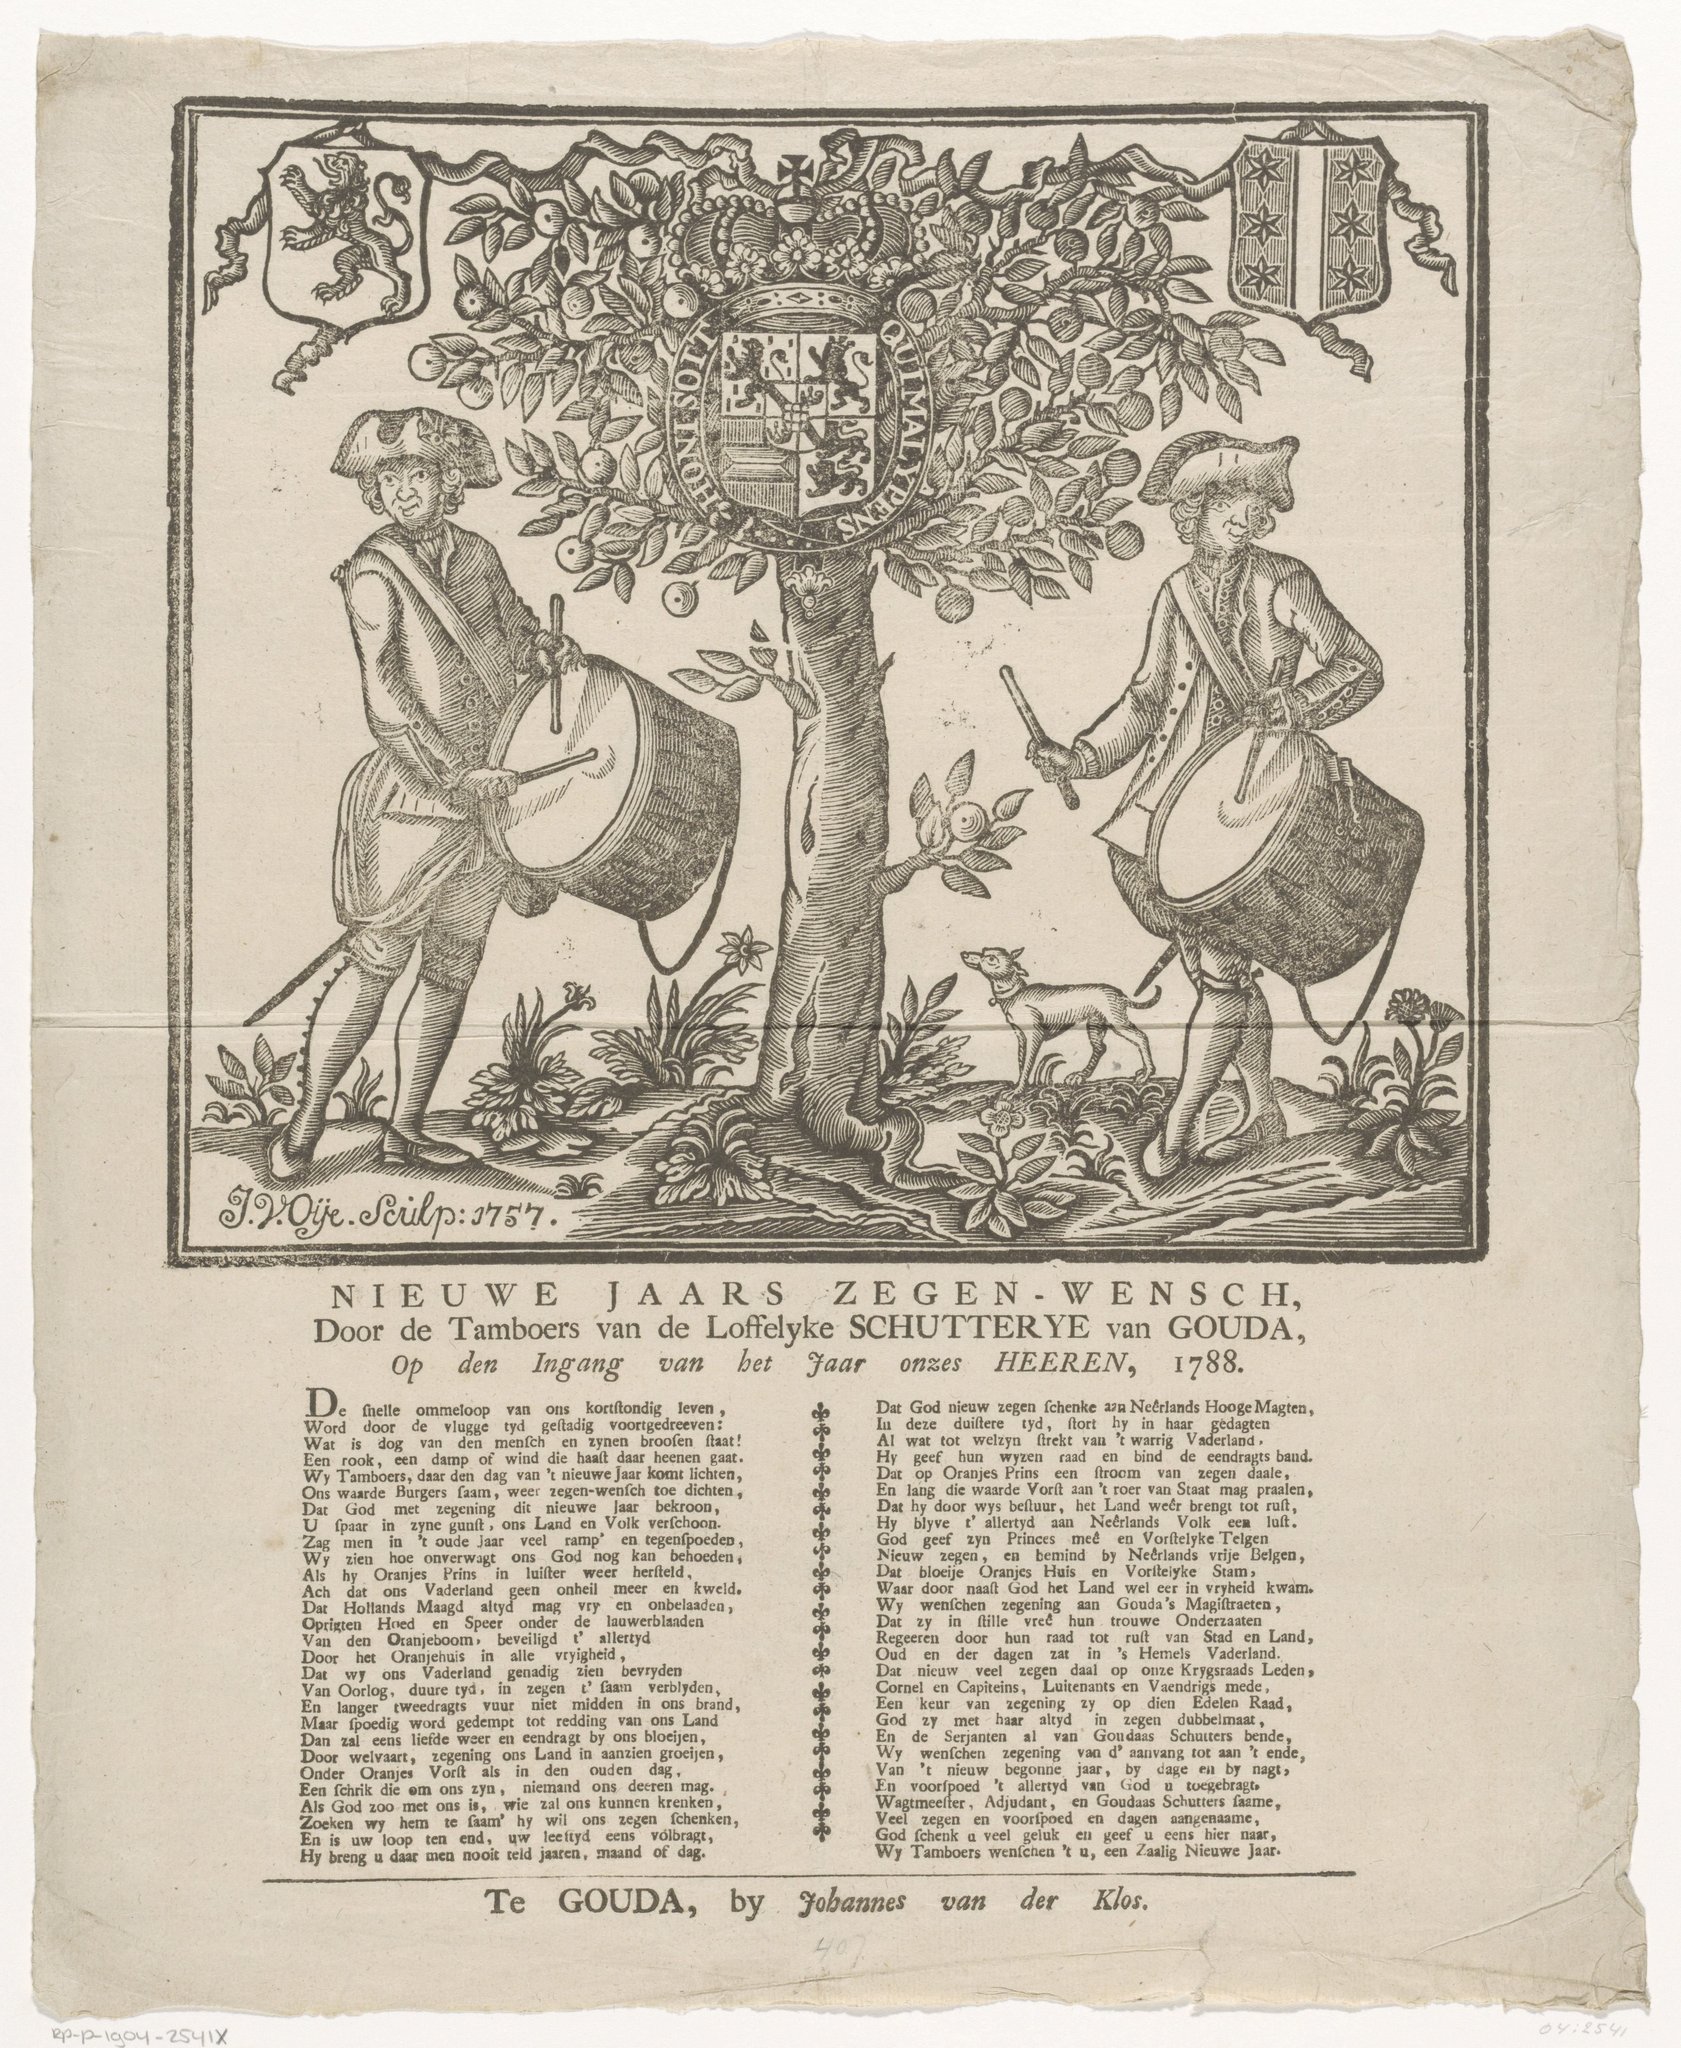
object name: new year card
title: Nieuwjaarswens van de tamboers van de schutterij van Gouda voor het jaar 1788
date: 1757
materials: paper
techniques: letterpress printing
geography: netherlands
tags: coat of arms (as symbol of the state, etc.), trees: orange-tree (+ bearing fruit), drum (musical instrument)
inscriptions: date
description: Midden boven twee tamboers onder een oranjeboom met drie wapens. Daaronder twee kolommen met elk 28 regels Nederlandse tekst.